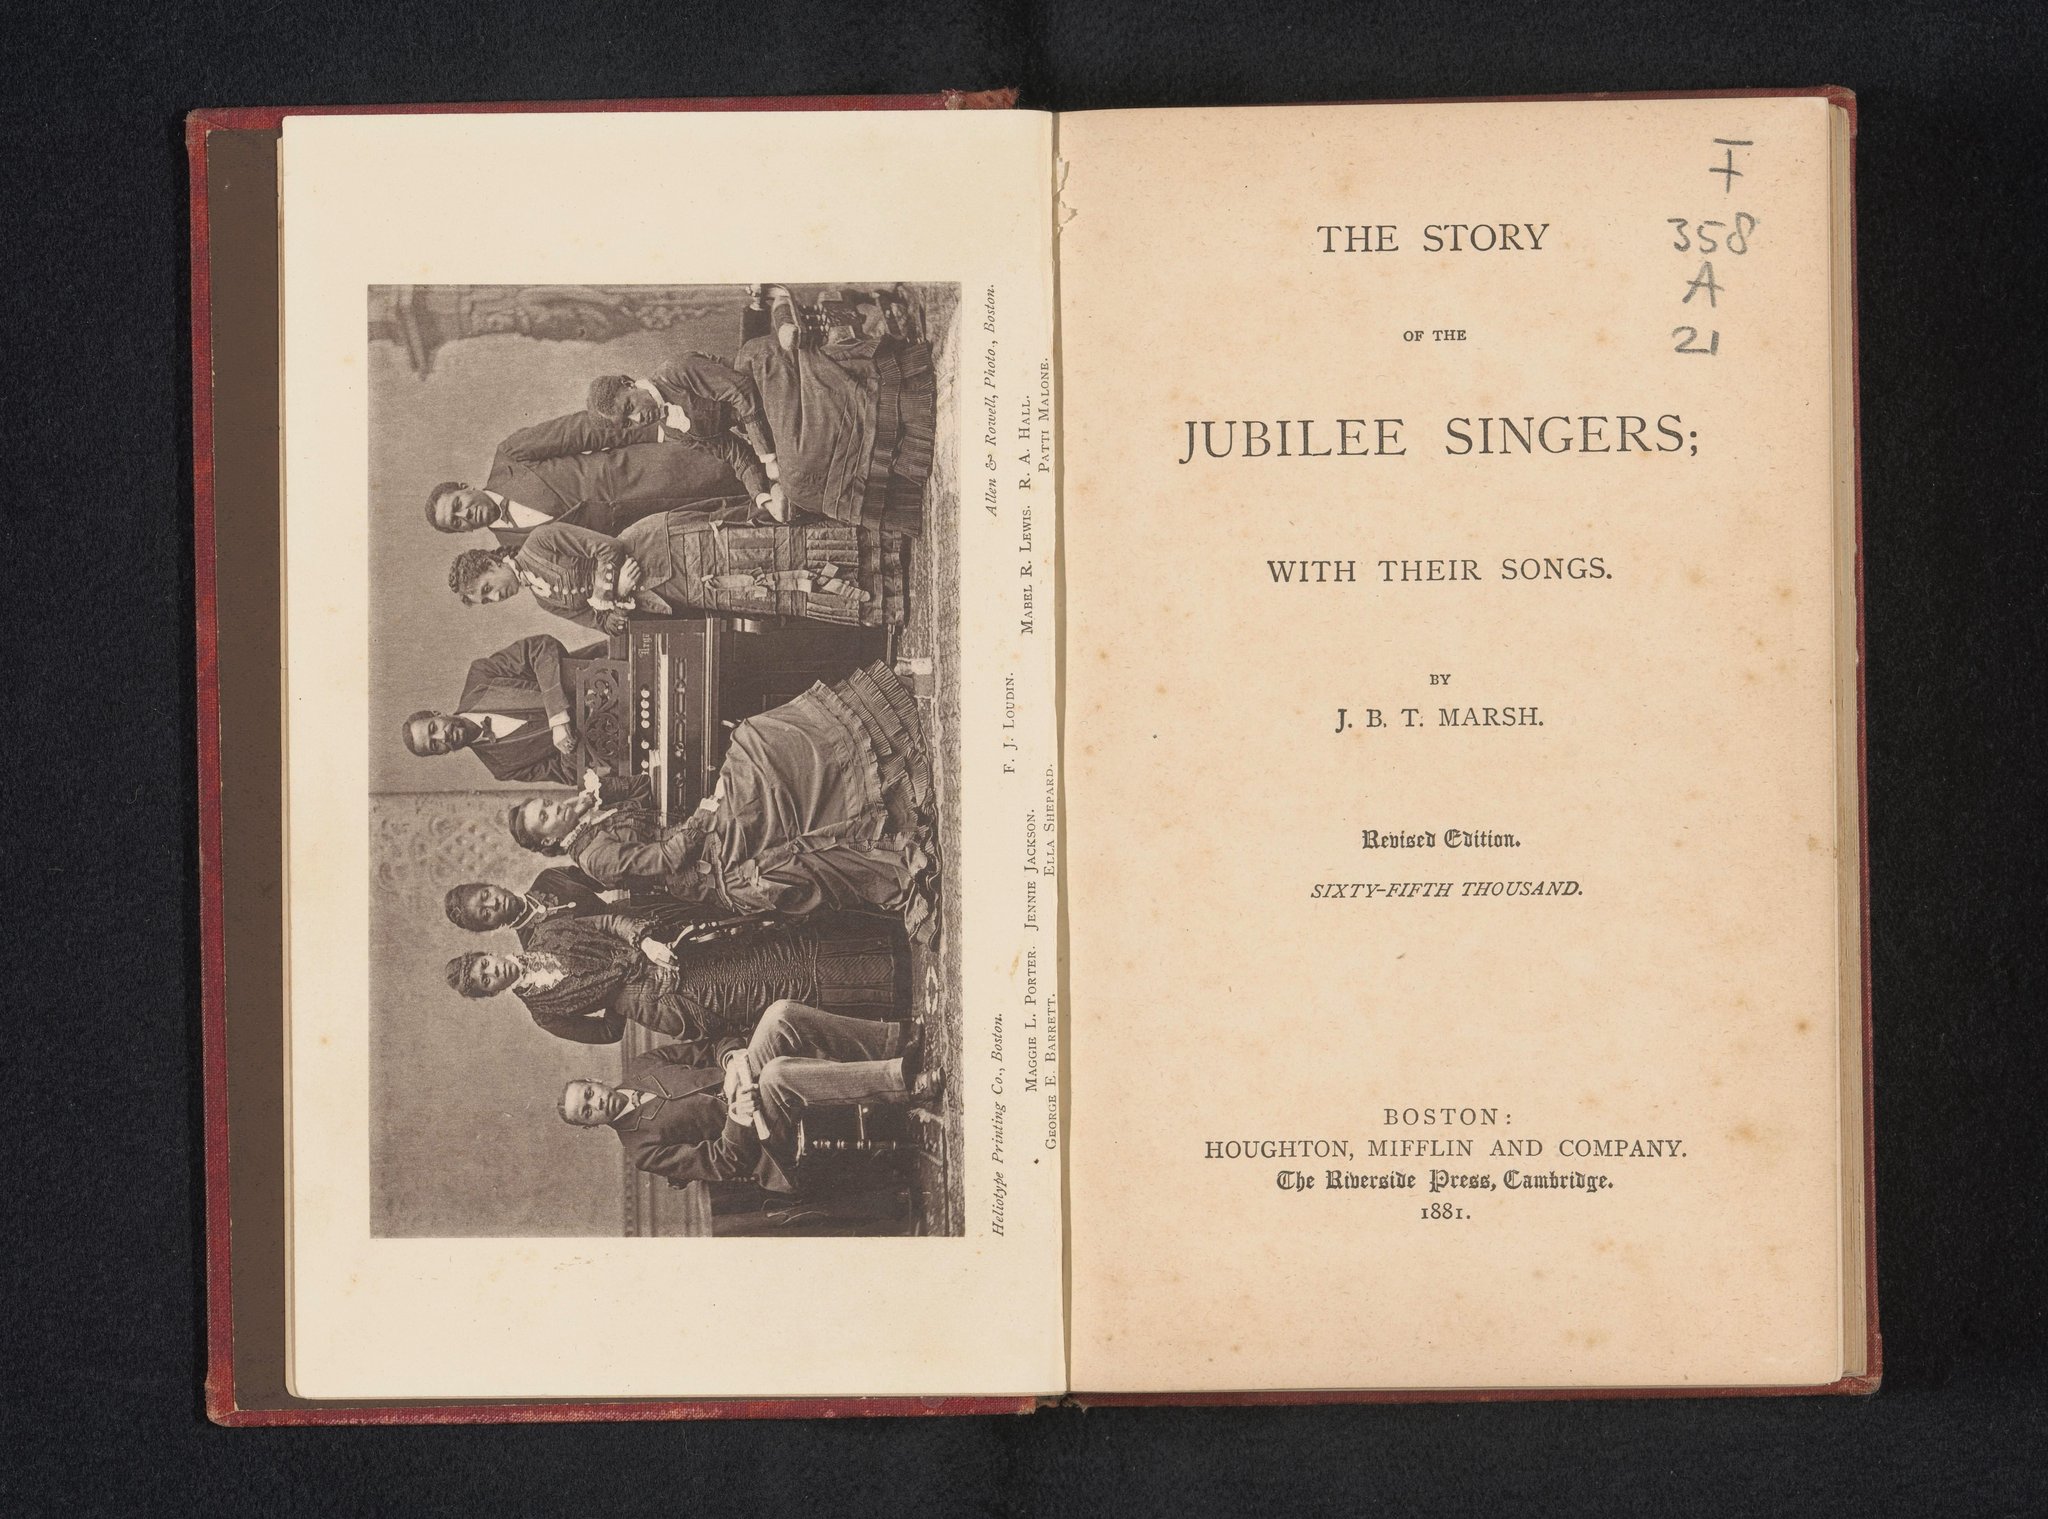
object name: photomechanical print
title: Portret van de Jubilee Singers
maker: Anonymous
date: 1876-1881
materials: paper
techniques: woodburytype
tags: choir, historical persons (portraits and scenes from the life)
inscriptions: inscription: ‘F.J. Loudin, Maggie L. Porter, Jennie Jackson, Mabel R. Lewis, R.A. Hall./ George E. Barret, Ella Shepard, Patti Malone’